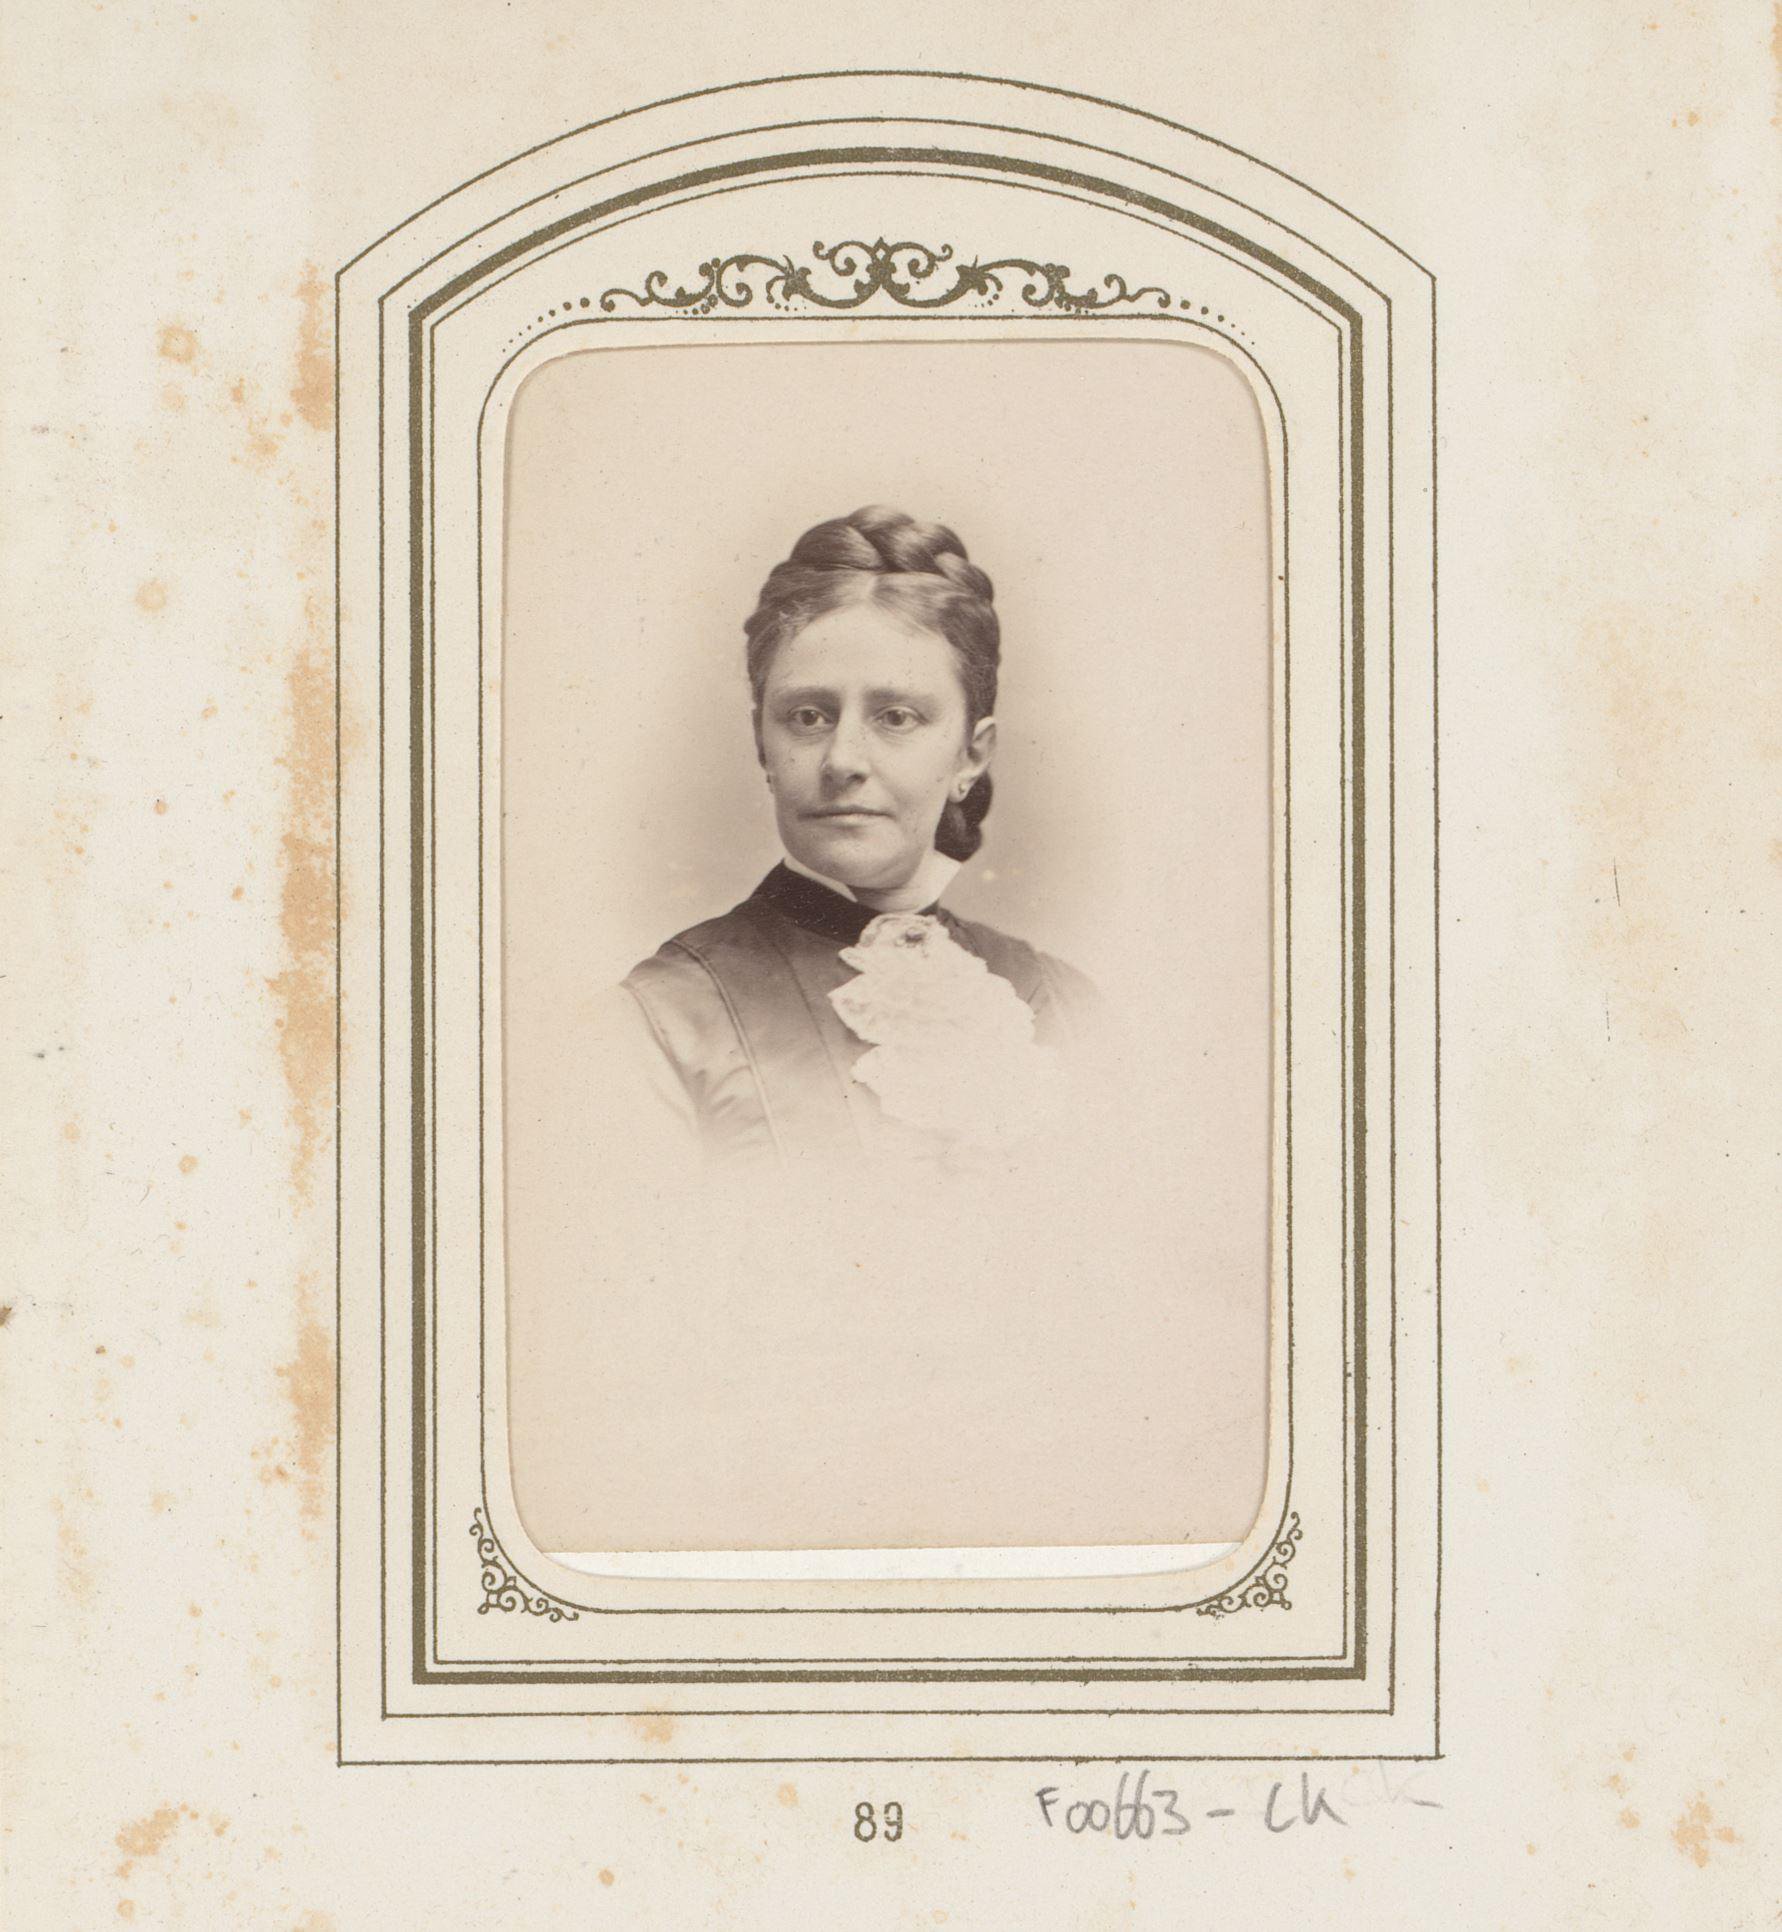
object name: photograph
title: Portret van een vrouw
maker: johannes petrus oppers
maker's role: fotograaf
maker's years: 1833-1890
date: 1860-1880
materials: cardboard, photographic support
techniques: albumen print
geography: amsterdam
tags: historical persons - bb - woman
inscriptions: number: ‘89’, inscription: ‘J.P. Oppers/ Photograaf (...) Kalverstraat, E.55/ Amsterdam’